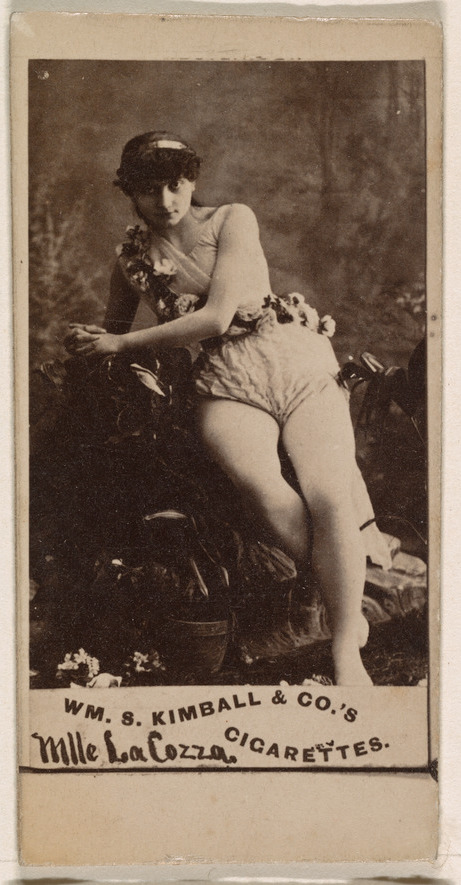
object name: photograph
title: Mlle. La Cozza, from the Actresses series (N203) issued by Wm. S. Kimball & Co.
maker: william s. kimball & company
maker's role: publisher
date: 1889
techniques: color lithograph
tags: portraits,women,actresses